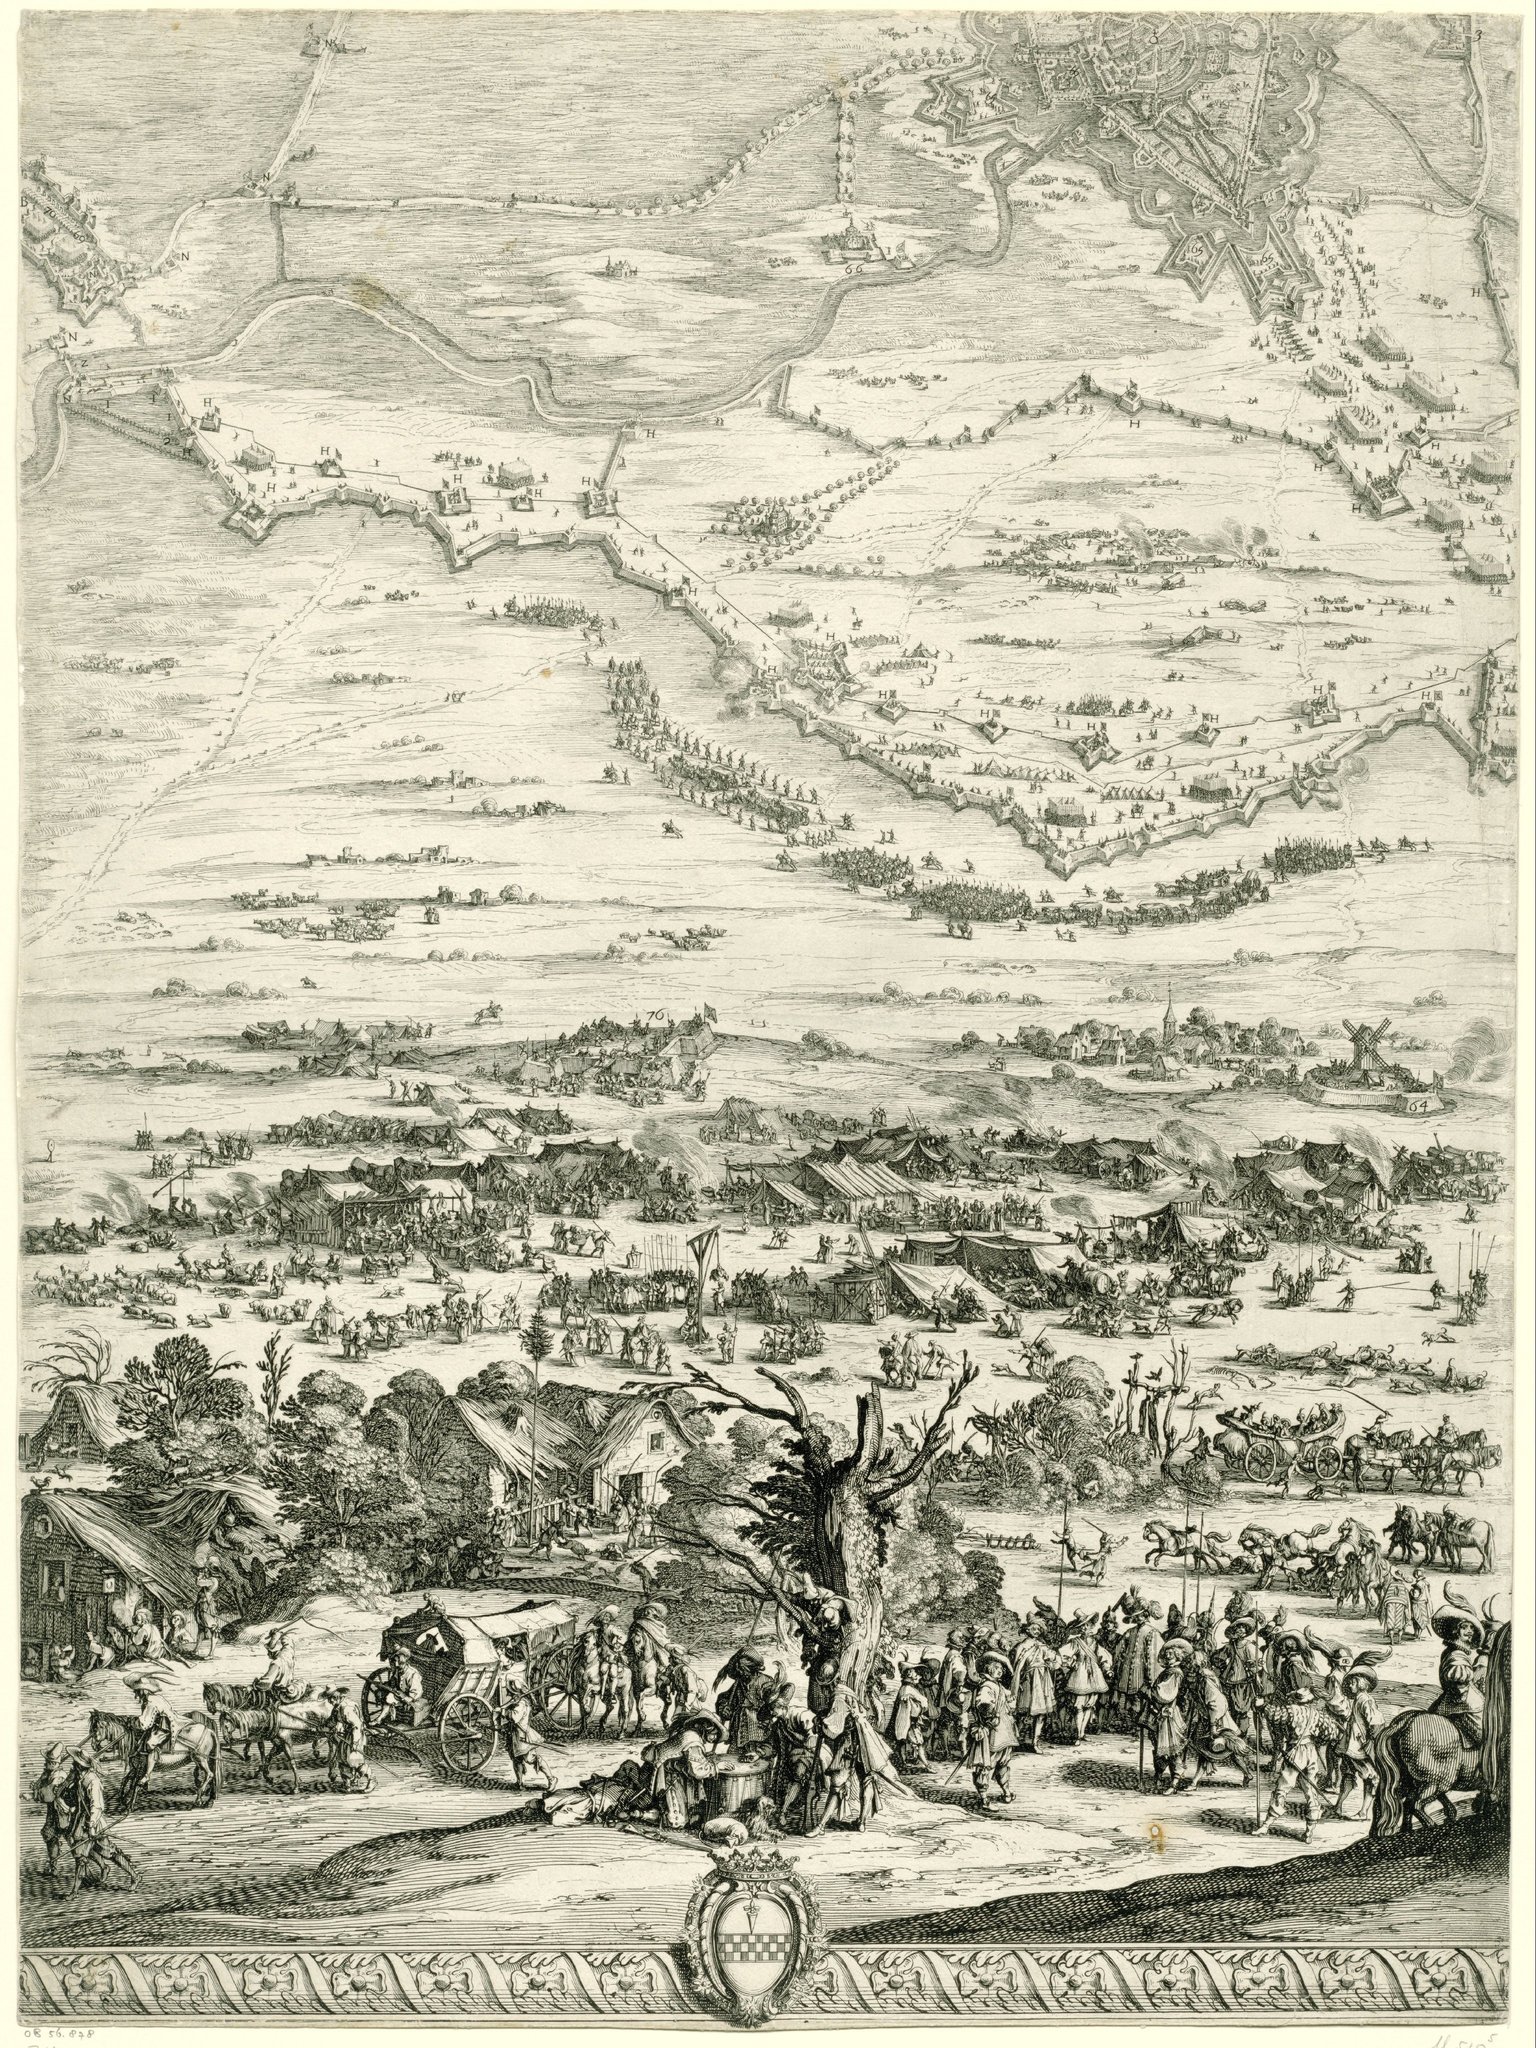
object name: history print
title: Beleg van Breda, 27 augustus 1624-5 juni 1625 (deel middenonder)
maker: jacques callot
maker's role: draughtsman, print maker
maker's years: 1592-1635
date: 1628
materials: paper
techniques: etching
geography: antwerp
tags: (military) camp with tents, maps of separate countries or regions, plundering ~ soldiers, siege, armorial bearing, heraldry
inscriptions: collector's mark: Lugt 240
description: Zesde deel (middenonder) van een voorstelling van het beleg van de stad Breda in de jaren 1624 en 1625 door de Spanjaarden onder aanvoering van Ambrogio Spinola. Op dit blad een deel van de belegeringswerken en kampementen om Breda, en een deel van de stad zelf. Voorts op het middenplan, recht onder Breda, een tentenkamp en op de voorgrond een (deel van een) dorpje dat door soldaten geplunderd wordt. Middenonder het wapen van Ambrogio Spinola. Onder de voorstelling een ornamentele rand.